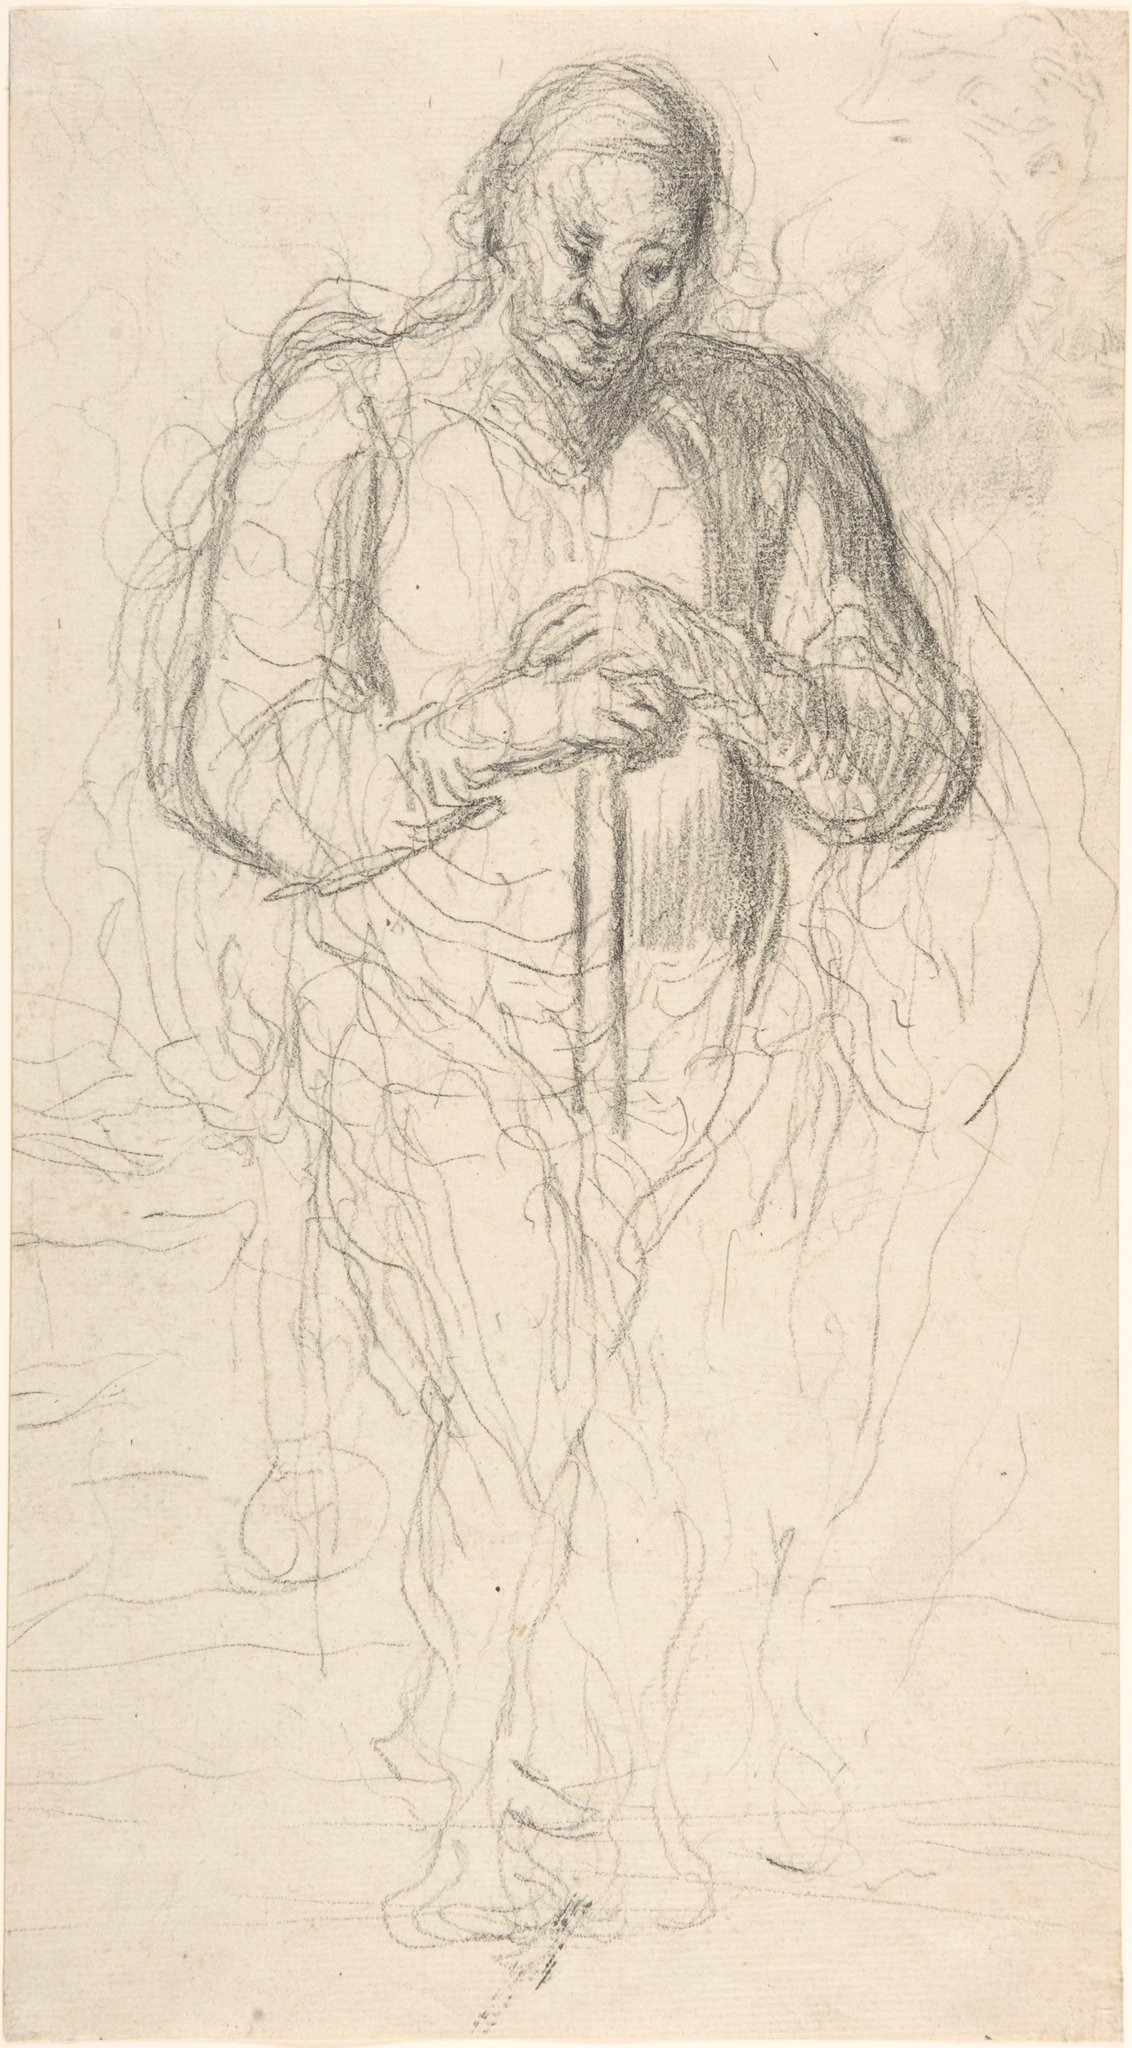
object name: drawing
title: Standing Figure of a Man with a Staff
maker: honoré daumier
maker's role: artist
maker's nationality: french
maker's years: 1808-1879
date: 1825-1879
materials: chalk, graphite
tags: men